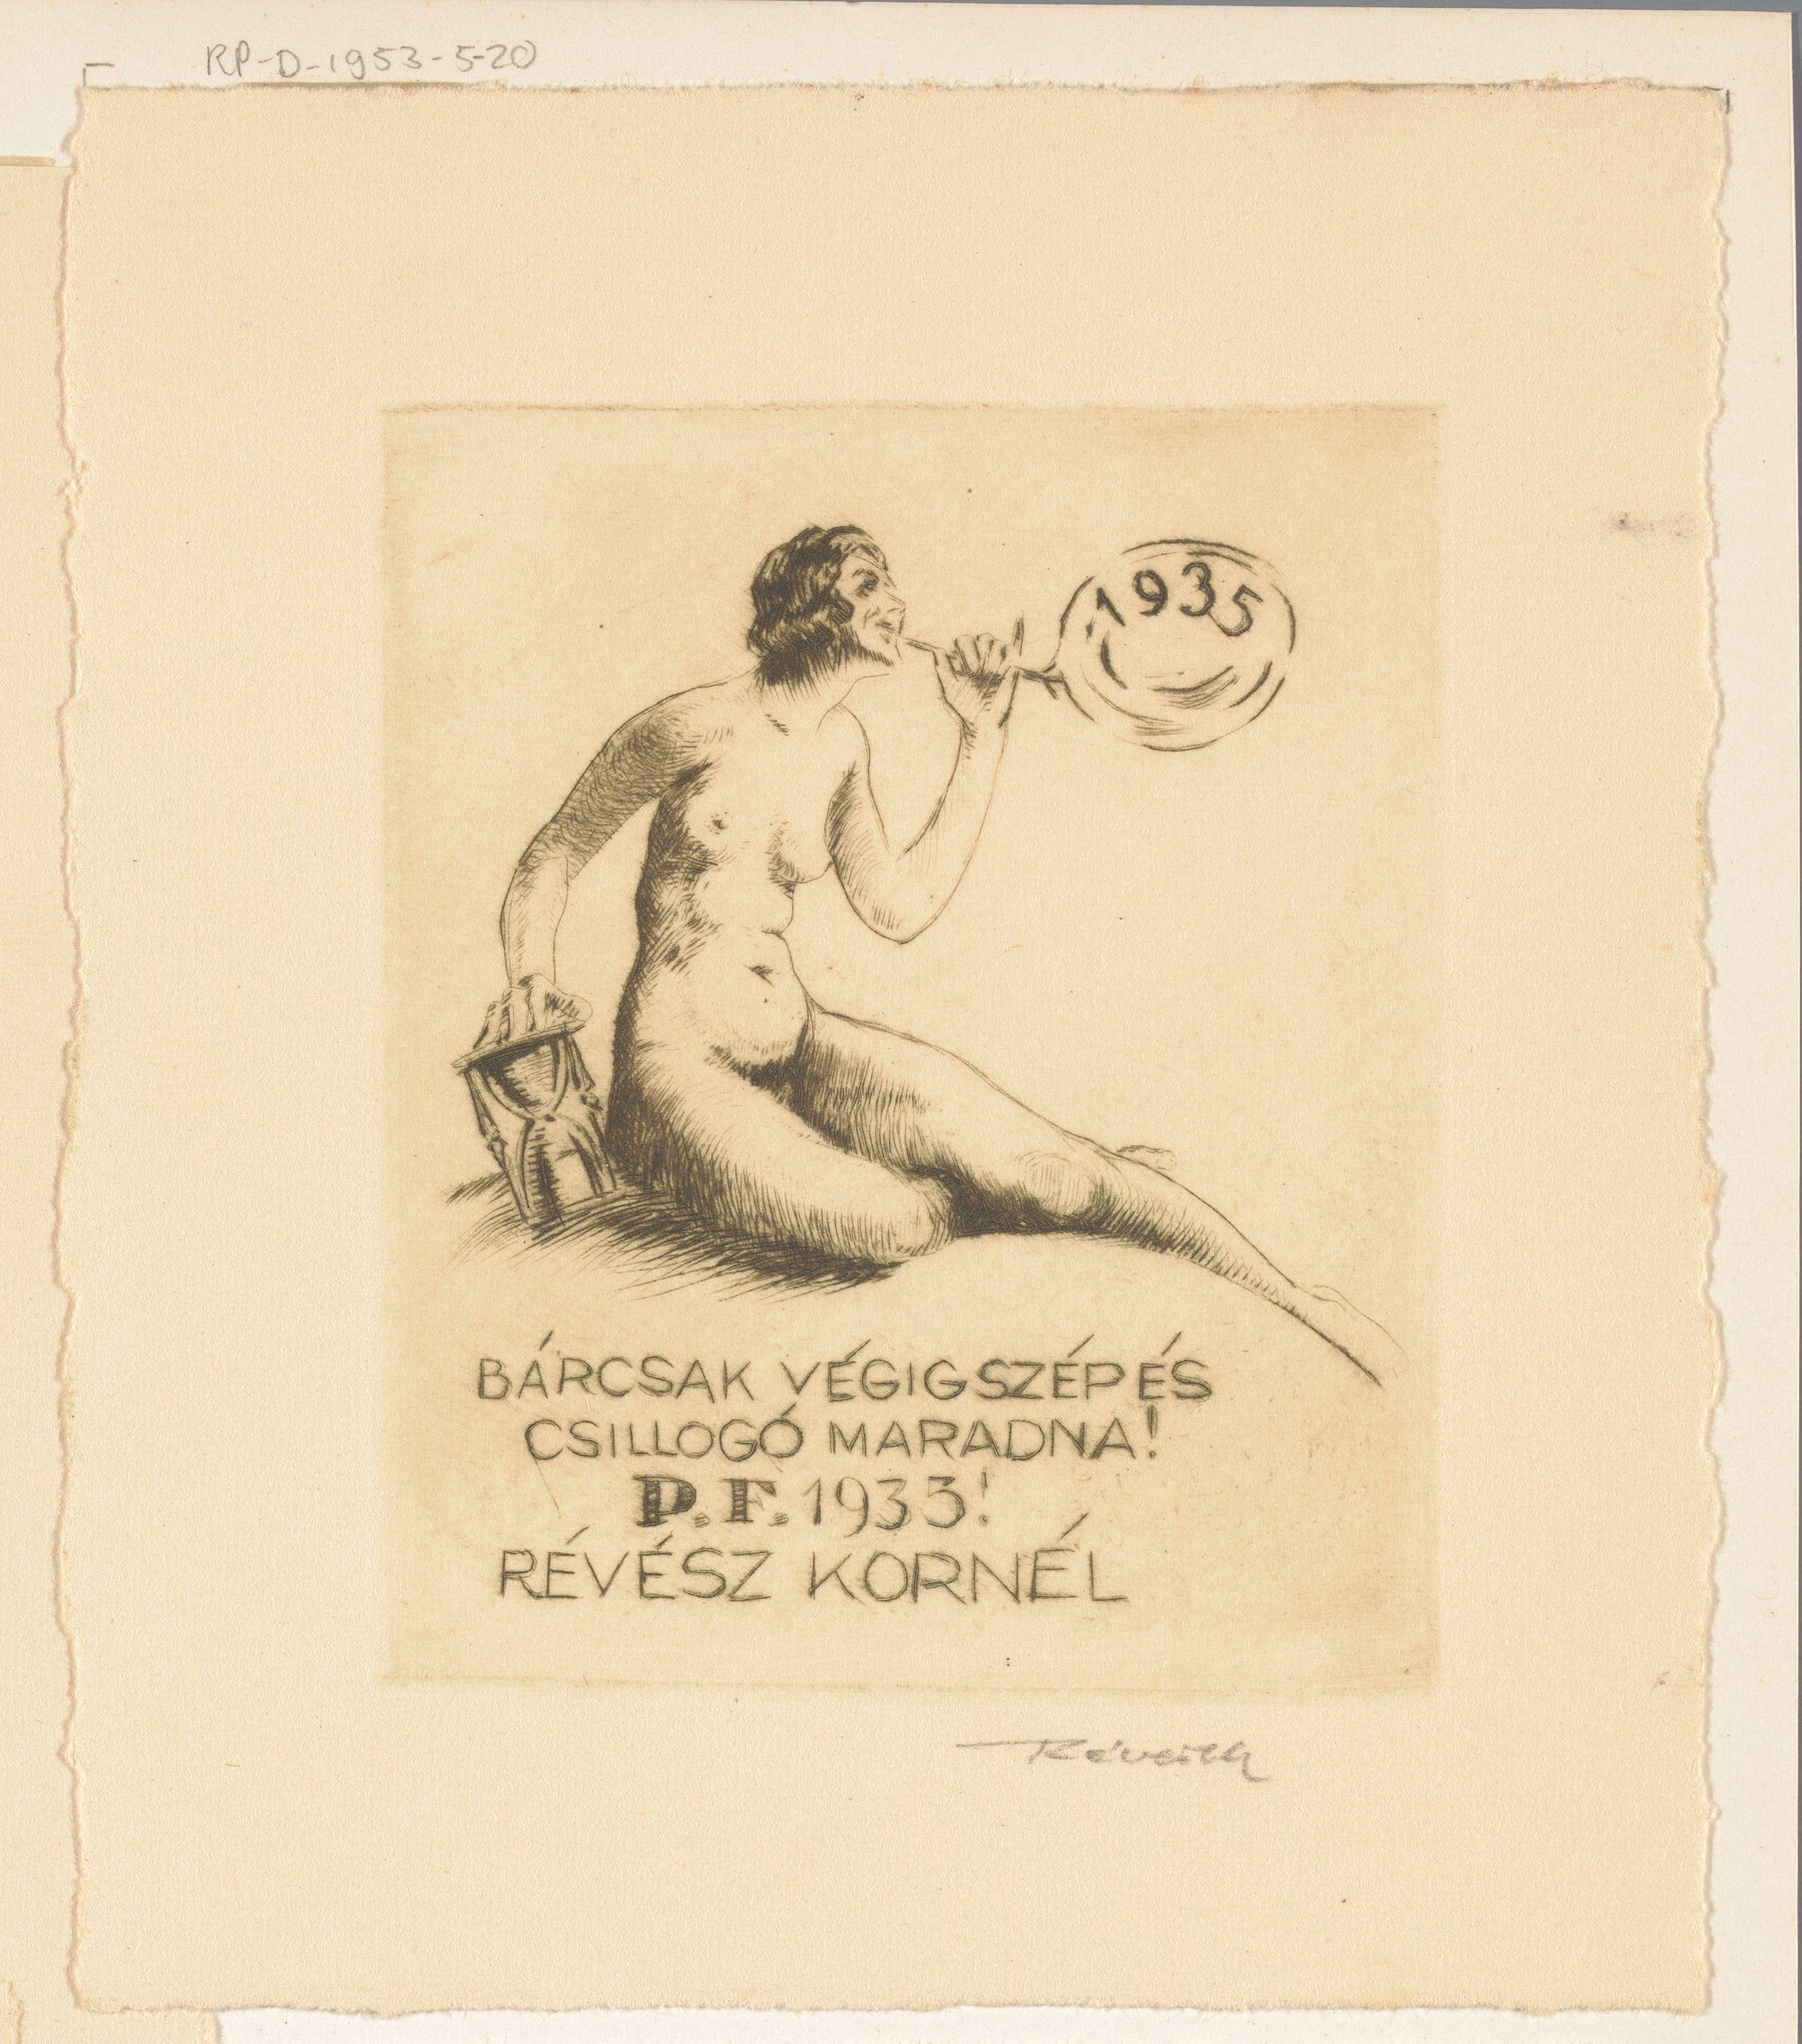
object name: new year card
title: Nieuwjaarswens van Kornél Révész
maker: kornél révész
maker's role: print maker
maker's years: 1885-1944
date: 1934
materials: paper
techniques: drypoint, etching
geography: budapest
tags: print maker, kornél révész, woman (showing herself) undressed, quasi-nude, hourglass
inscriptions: date: ‘Nr. 107/ 1934’, workshop stamp: ‘Fecit/ Révész Kornél/ Budapest’, signature: ‘Révész’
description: Ex libris maakt deel uit van omslag met 64 ex libris op 34 losse opzetvellen, een catalogus en een tekstblad.